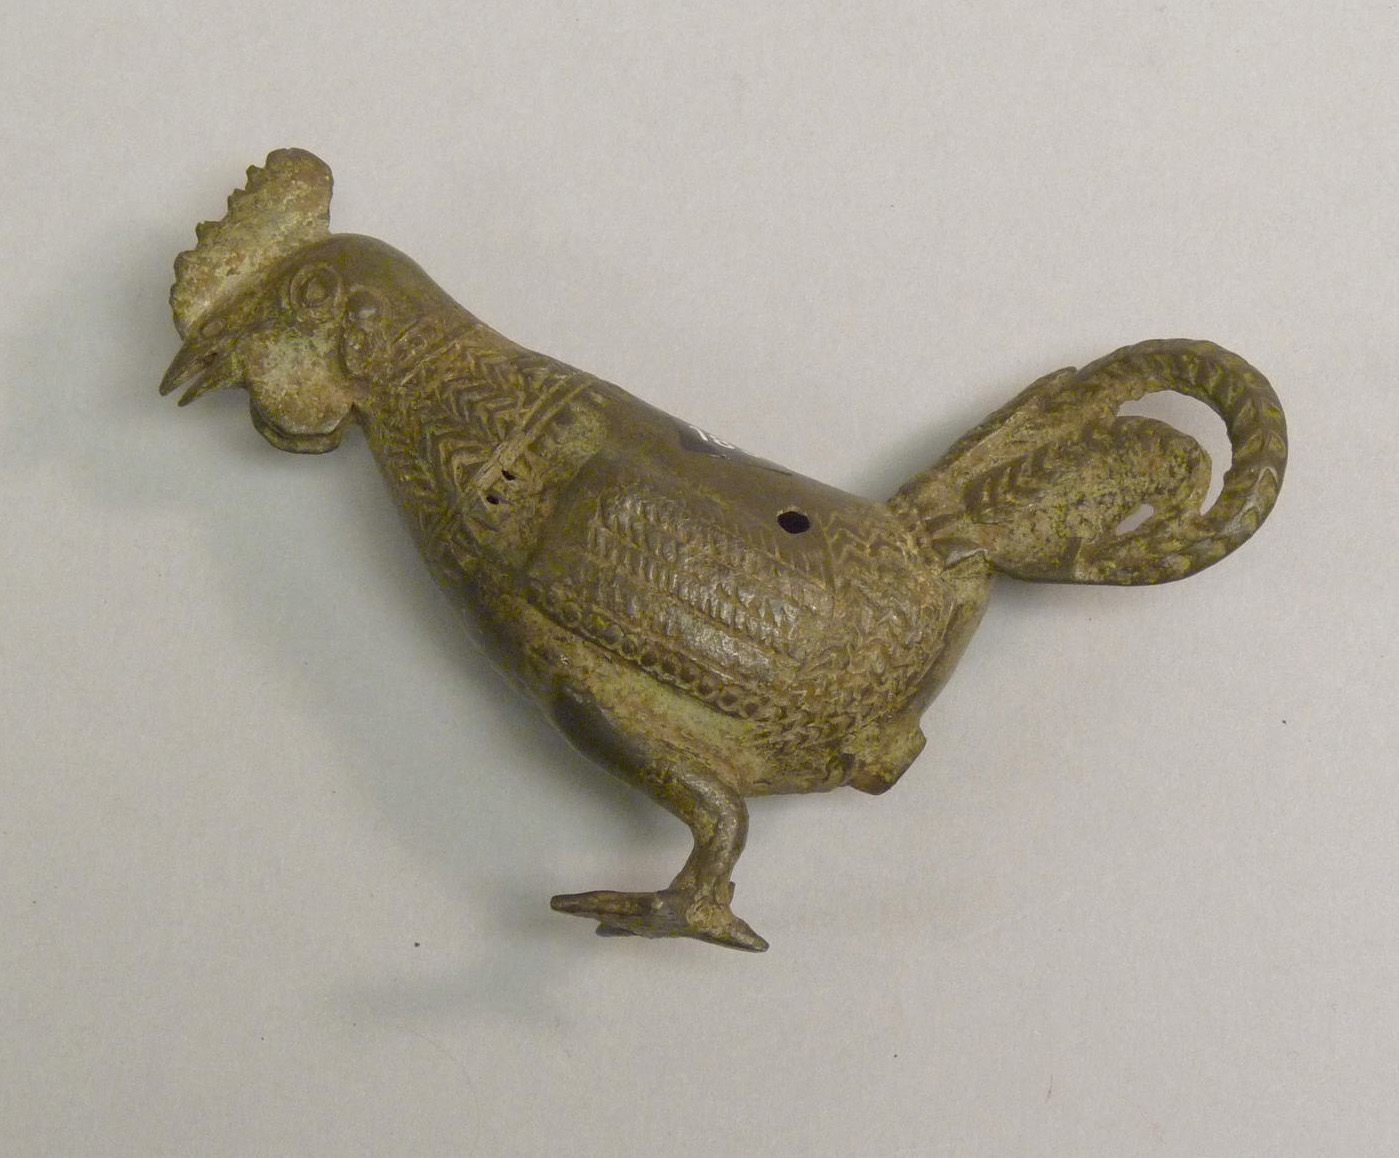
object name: vessel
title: Lime Vessel in the Form of a Cock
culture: indonesian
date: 500 BCE-300 CE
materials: bronze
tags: roosters